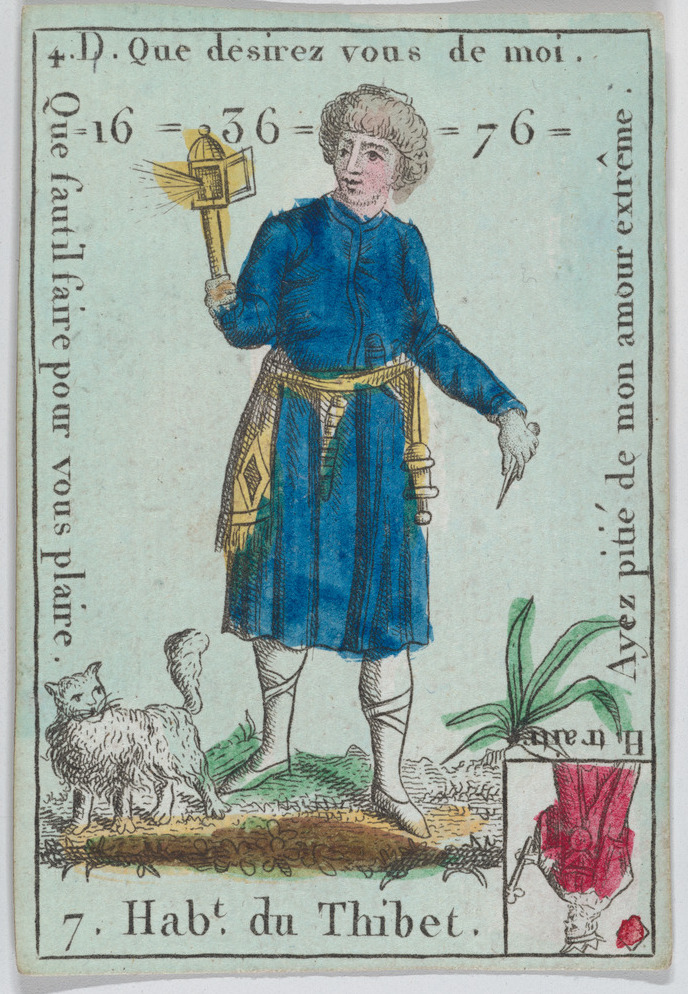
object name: print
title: Hab.t du Thibet from playing cards "Jeu d'Or"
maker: anonymous, french, 18th century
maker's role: artist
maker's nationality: french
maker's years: 1700-1800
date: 1700-1799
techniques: etching, hand coloring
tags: animals,men,playing cards